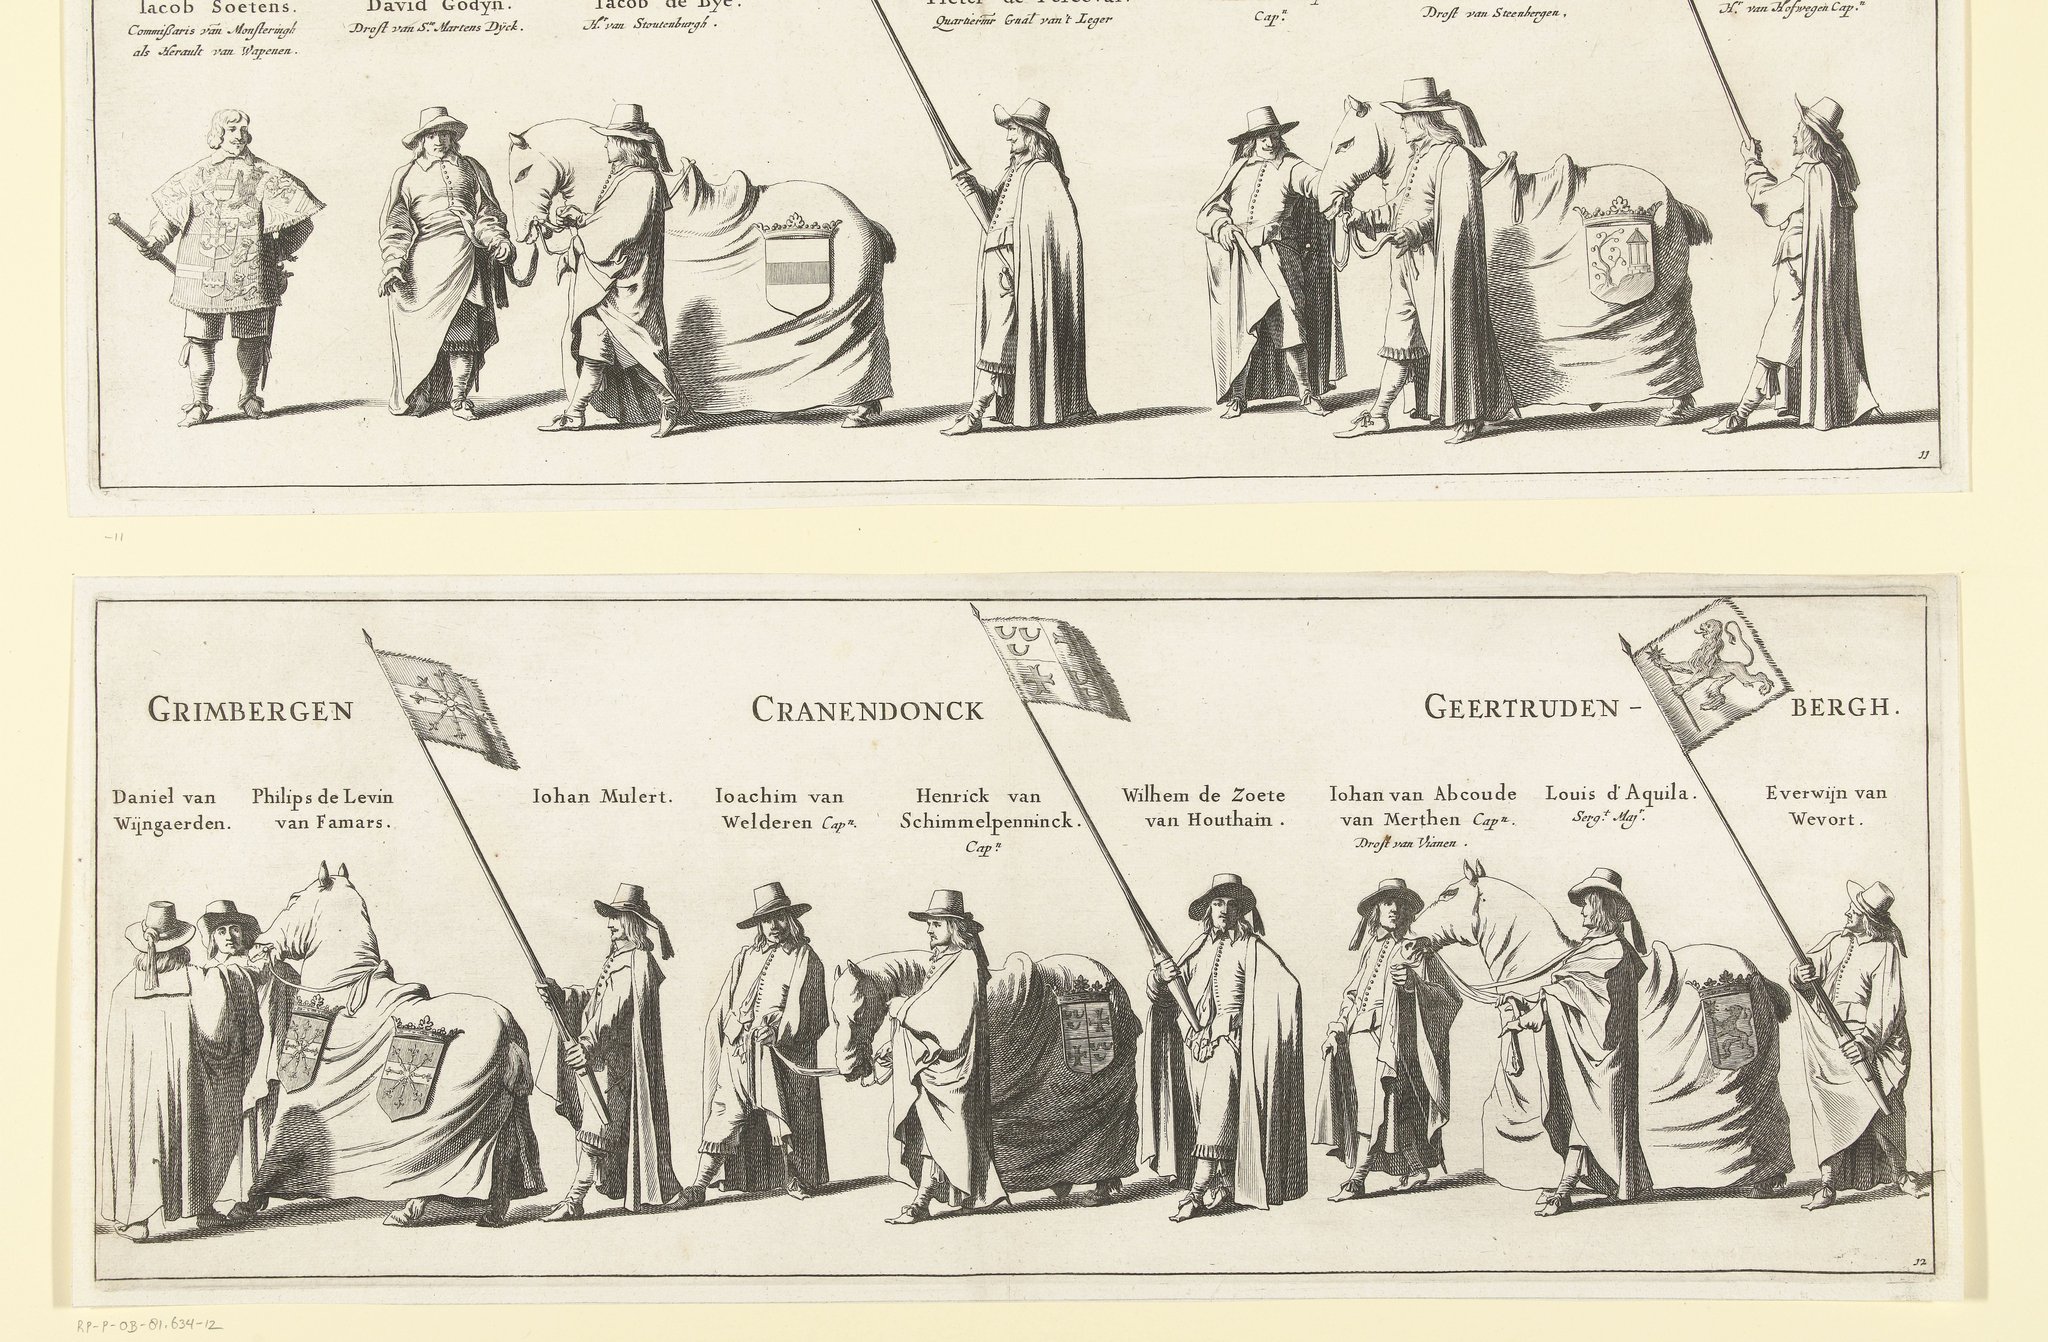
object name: print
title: Begraeffenisse van Syne Hoogheyt Frederick Henrick, by der Gratien Gods Prince van Orange, Grave van Nassau &c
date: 1647-1651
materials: paper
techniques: etching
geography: northern netherlands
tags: delft, the hague, frederick henry (prince of orange), cortege, funeral procession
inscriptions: collector's mark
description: De begrafenisstoet van stadhouder Frederik Hendrik te 's-Gravenhage op 10 mei 1647. Plaat nr. 12 met een deel van de stoet met vaandeldragers en drie paarden, boven de personen staan hun naam en functie. Onderdeel van een serie van 30 platen en 20 tekstbladen, bedoeld om aan elkaar geplakt te worden.